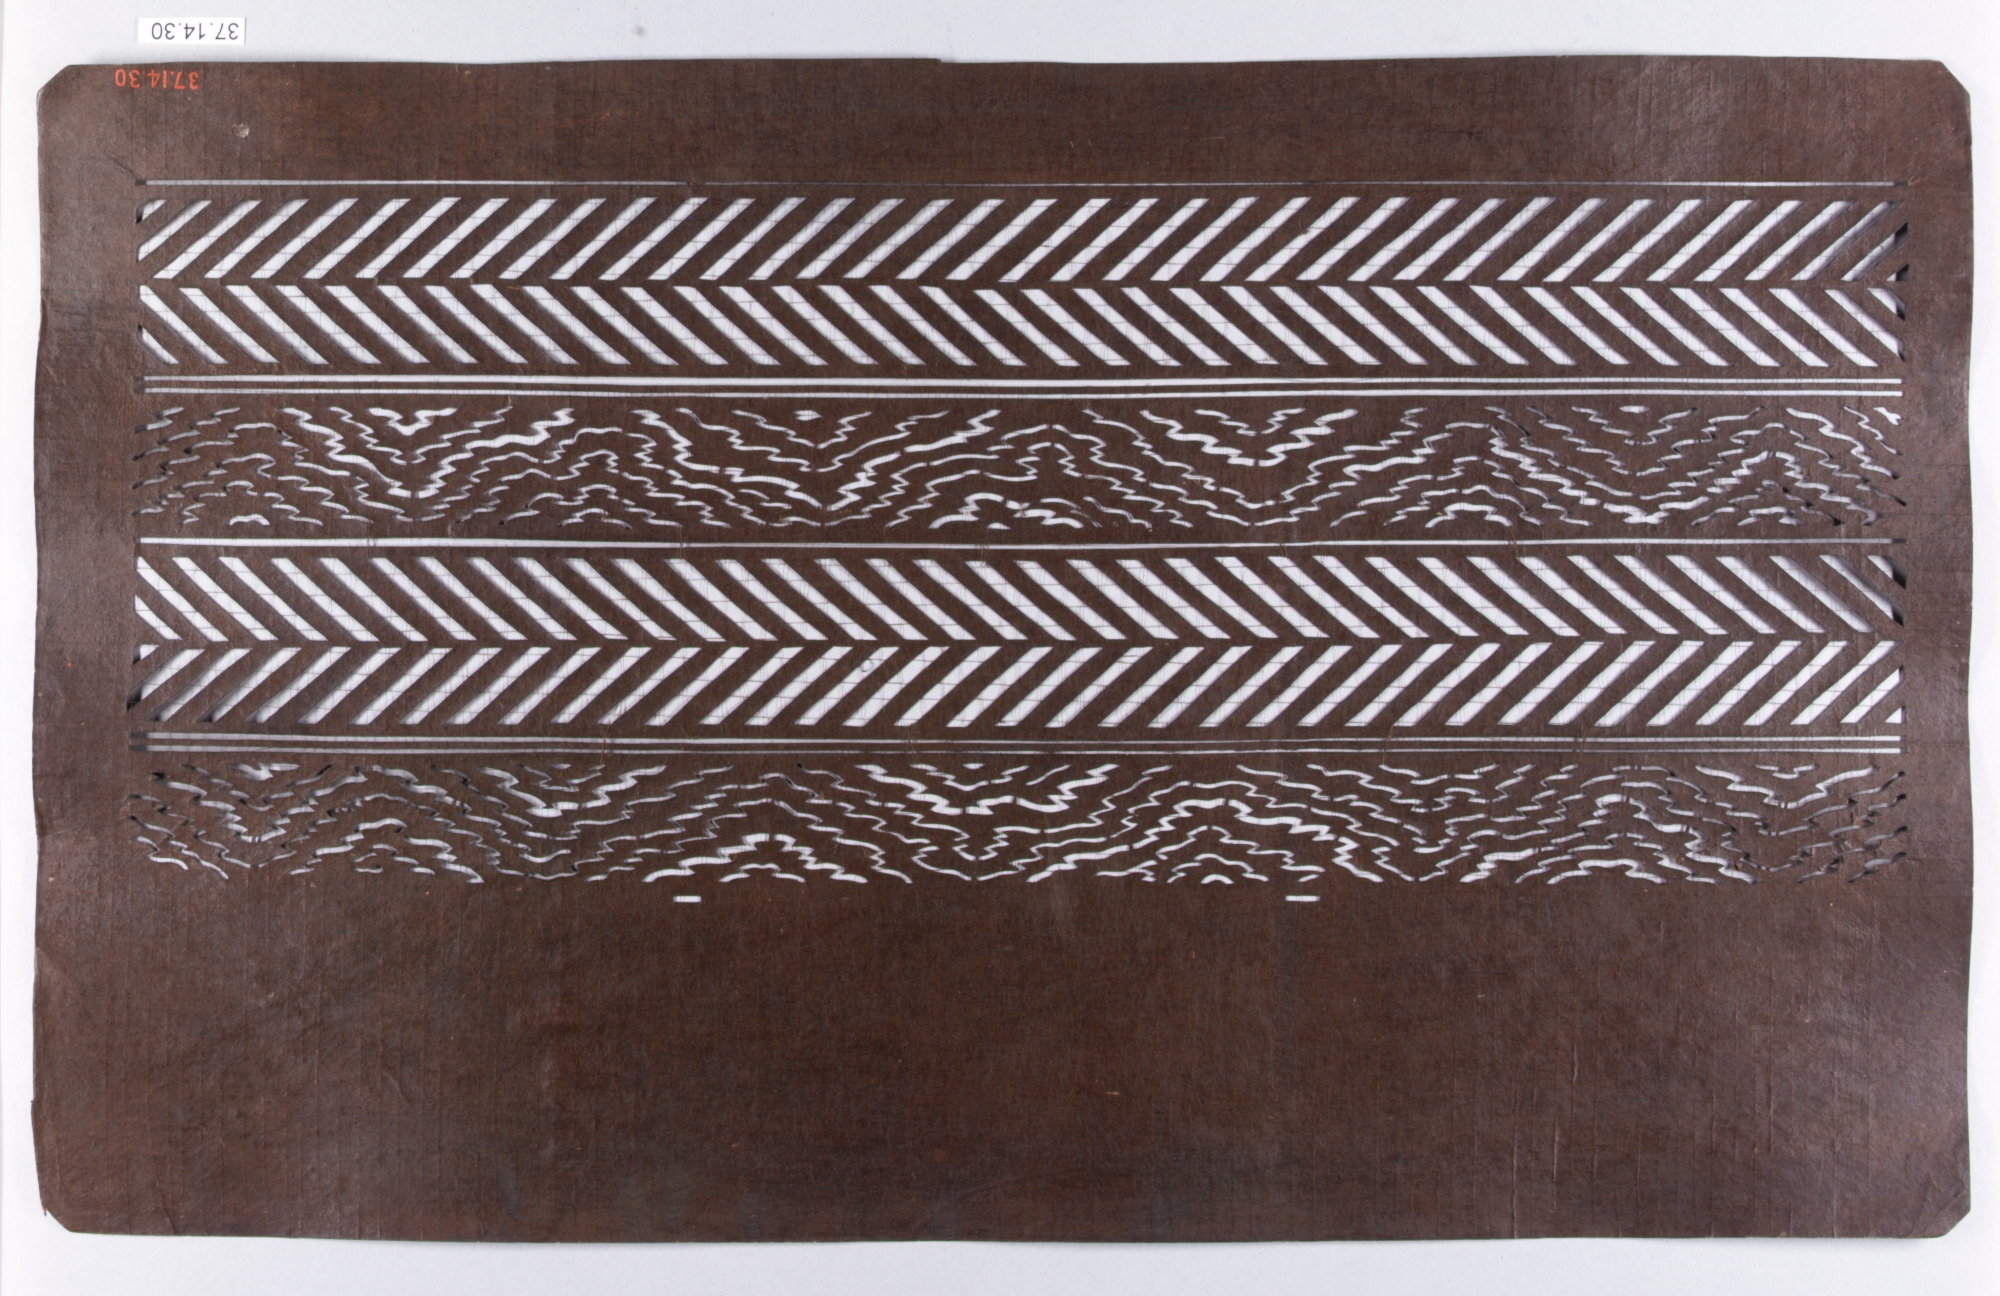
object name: stencil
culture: japanese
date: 1801-1833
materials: paper, silk